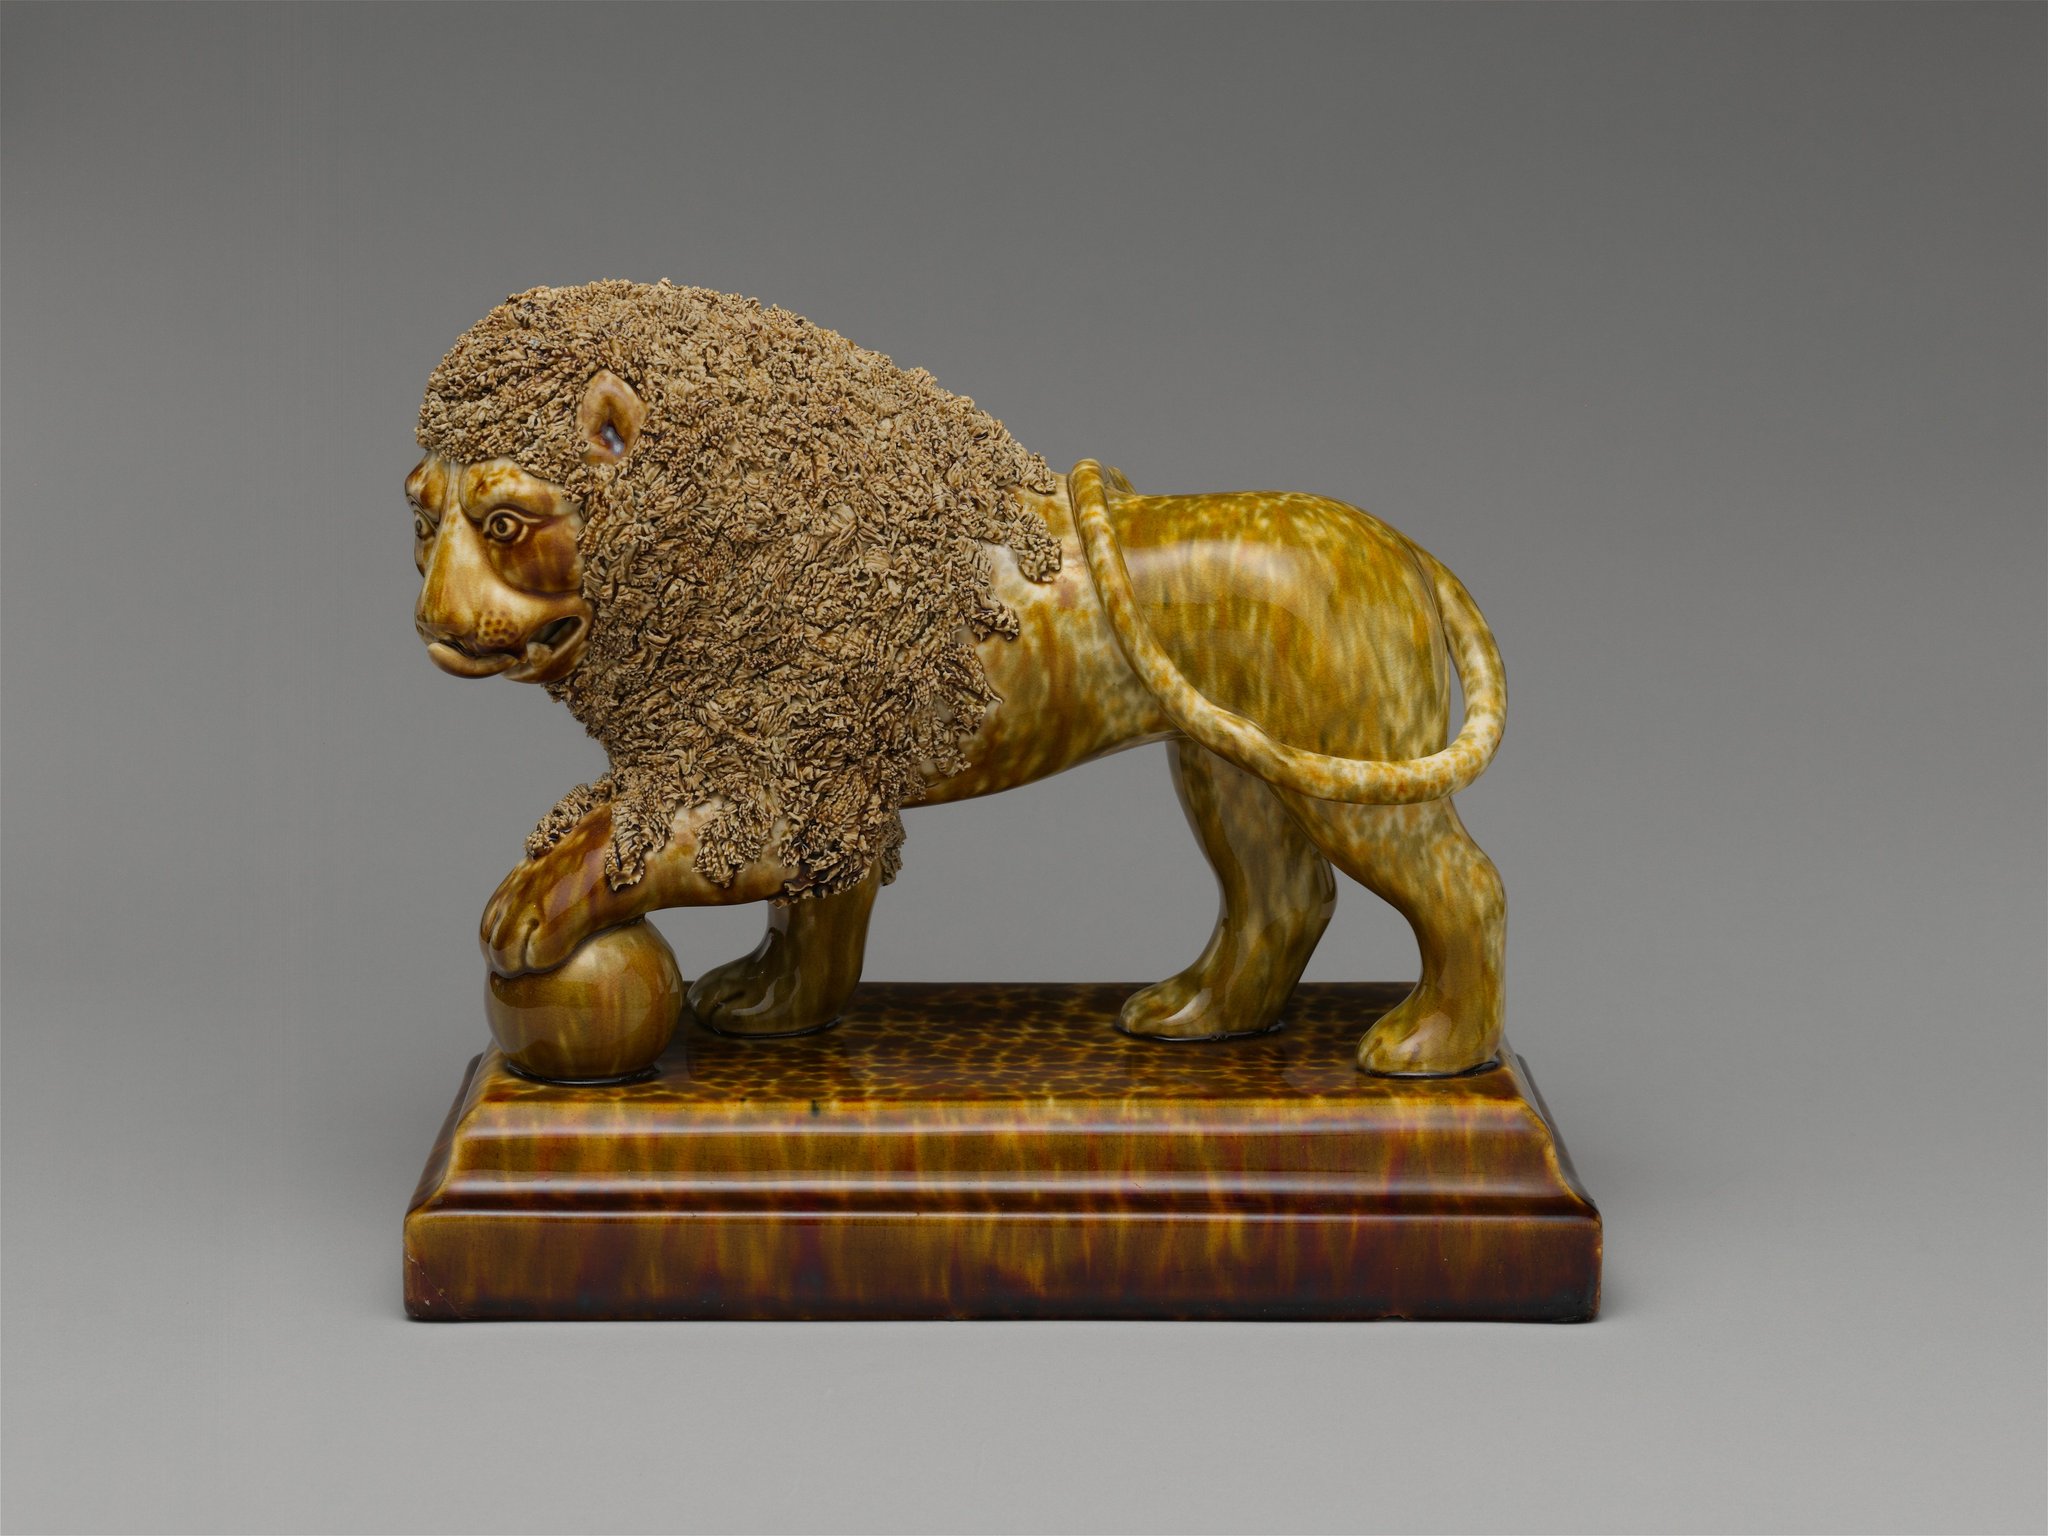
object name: figure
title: Standing lion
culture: american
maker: daniel greatbatch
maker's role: designer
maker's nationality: british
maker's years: 1838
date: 1849-1852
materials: earthenware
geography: united states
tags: lions